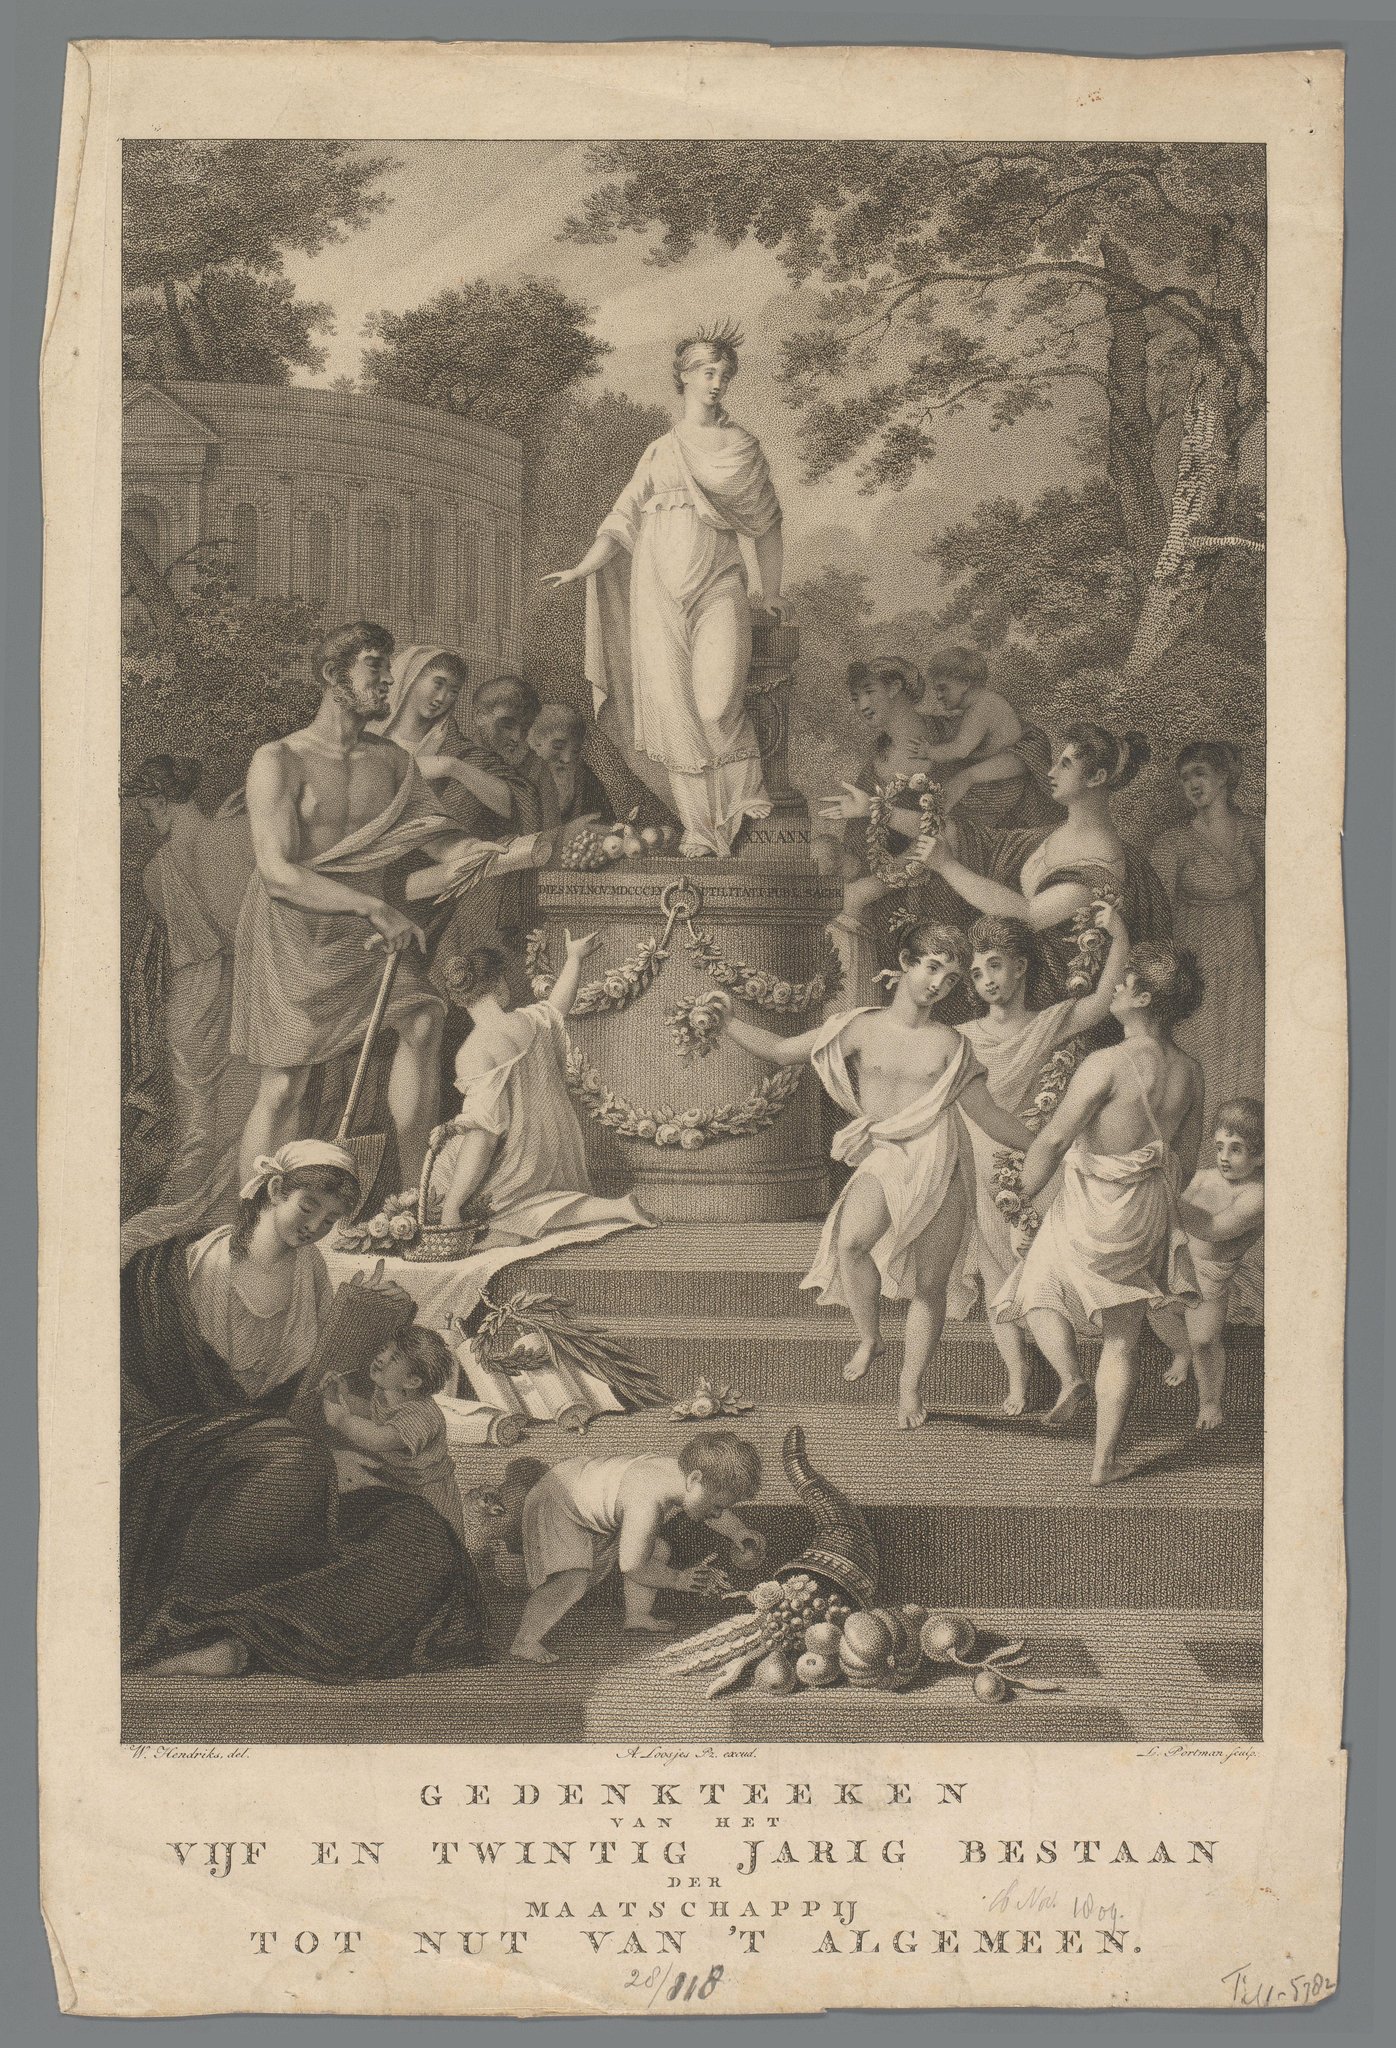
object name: print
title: Allegorie op het 25-jarig bestaan van de Maatschappij tot Nut van 't Algemeen, 1809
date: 1809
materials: paper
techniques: etching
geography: amsterdam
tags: charity, 'caritas'; 'carità' (ripa) ~ one of the three theological virtues, symbolic representations, allegories and emblems ~ education; 'ammaestramento', dottrina', 'educatione', 'istitutione' (ripa) (+ variant), netherlands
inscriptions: collector's mark: Lugt 2228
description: Allegorische voorstelling met de personificatie van de Maatschappij op een met guirlandes versierde sokkel. Rondom het beeld diverse allegorische figuren die haar geschenken brengen. Eén van hen biedt haar een bloemenkrans aan. Kinderen dansen in een kring voor de sokkel. Links op de voorgrond Liefde. Een van de kinderen reikt naar de vruchten uit de hoorn des overvloeds (het kind plukt reeds de vruchten van de stichting van de Maatschappij). Met de tekst: 'Gedenkteeken van het vijf en twintig jarig bestaan der Maatschappij tot Nut van 't Algemeen'.